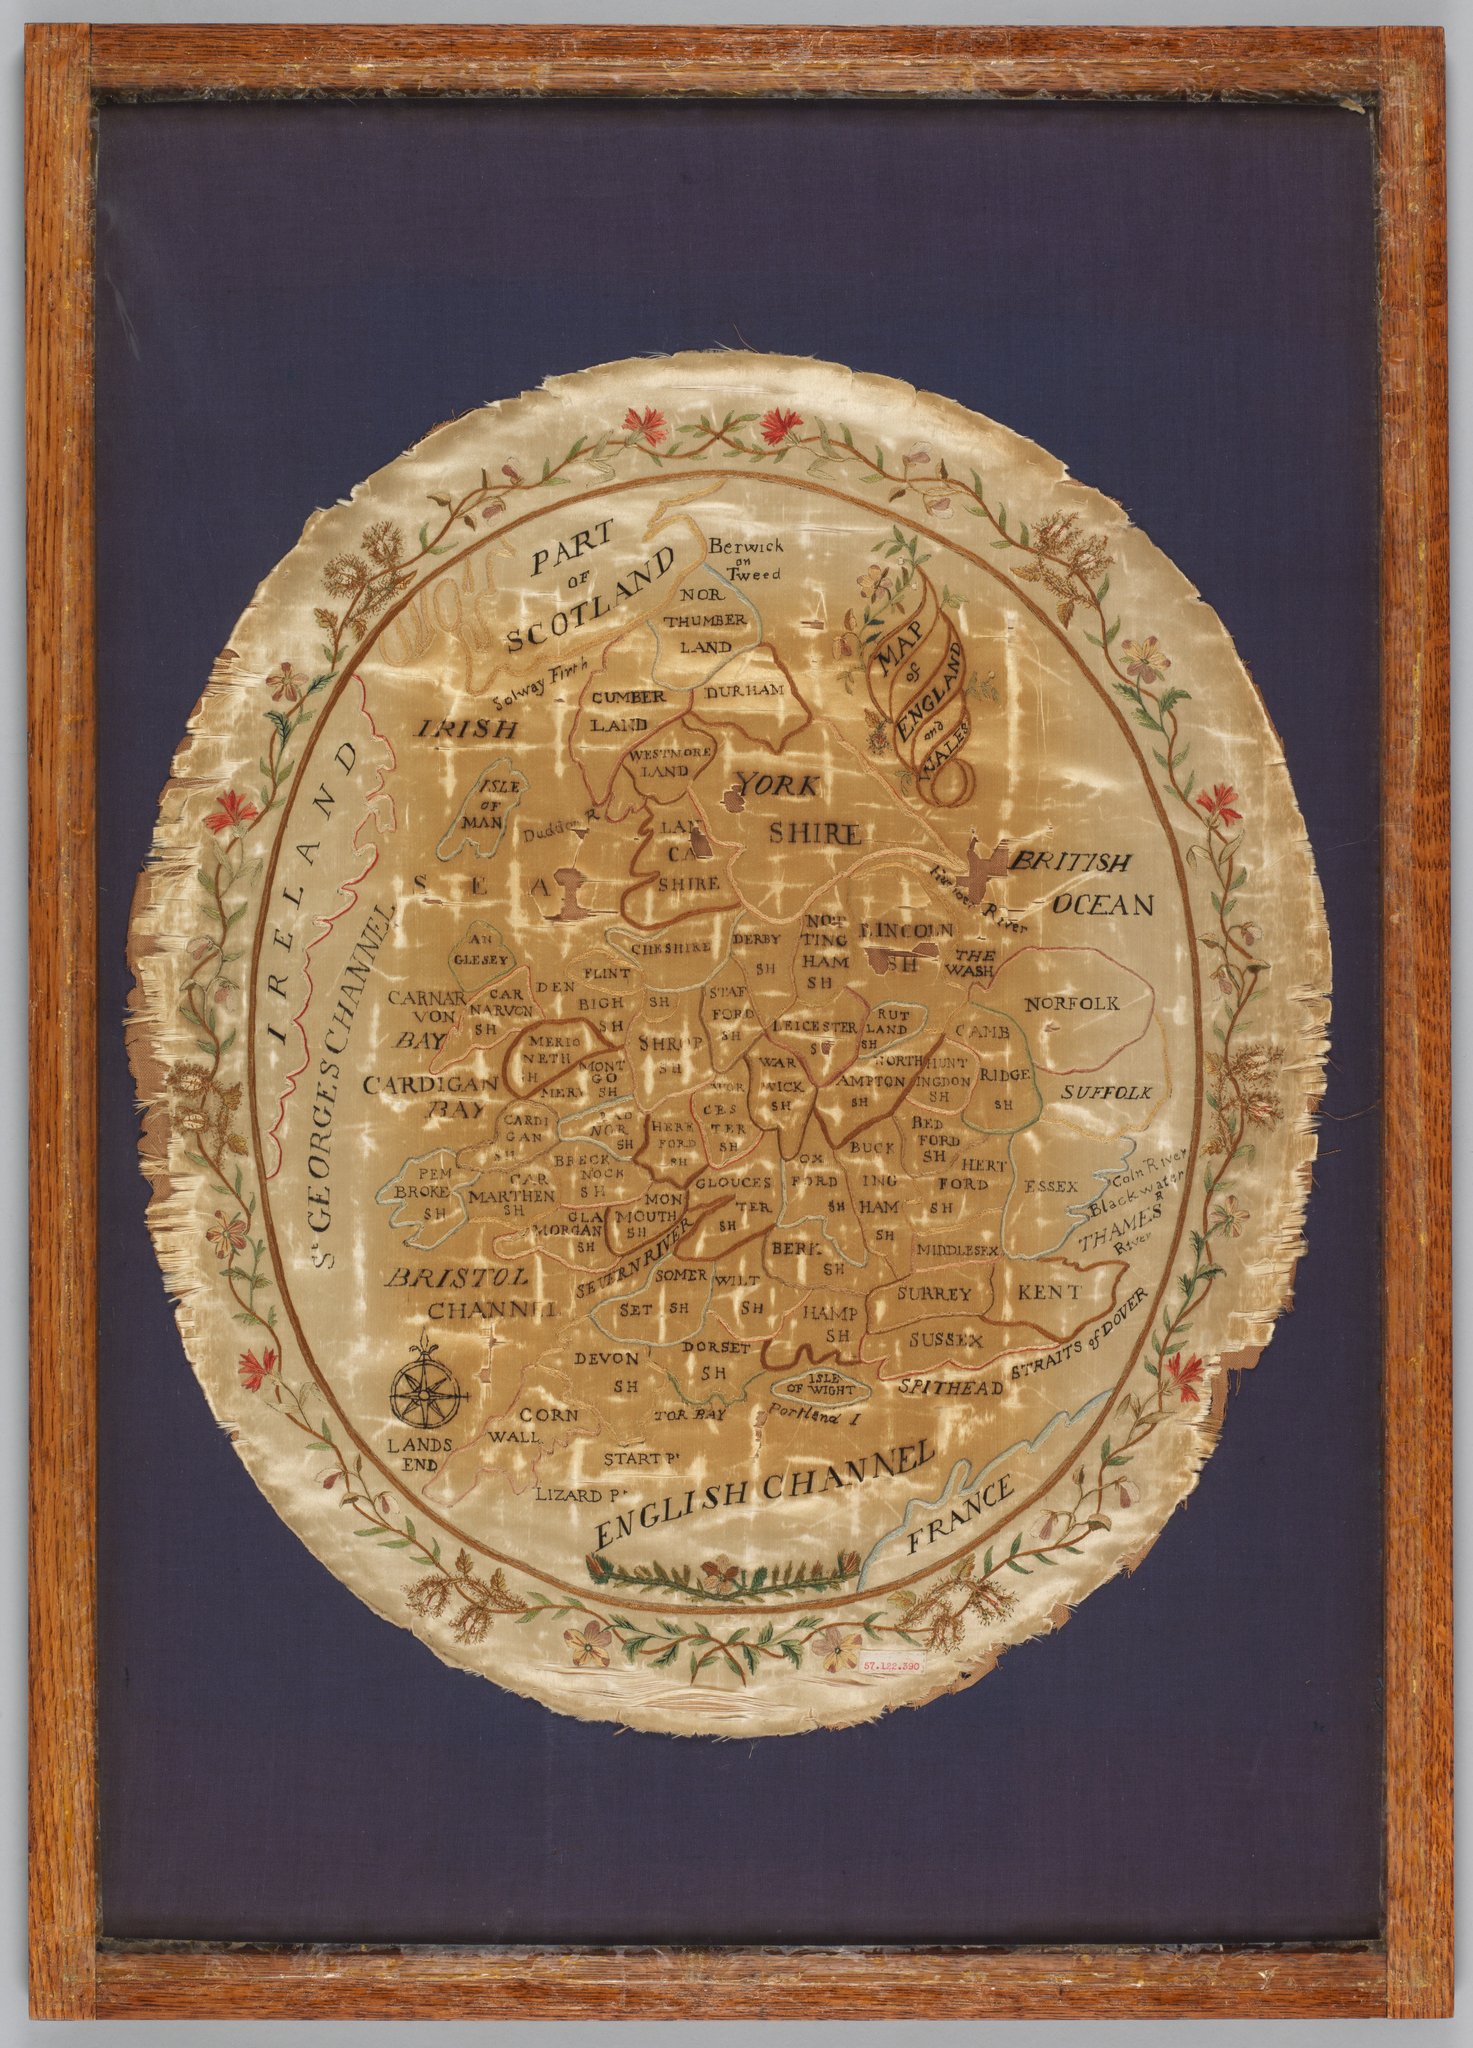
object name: sampler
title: Embroidered map sampler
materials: silk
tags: flowers,maps